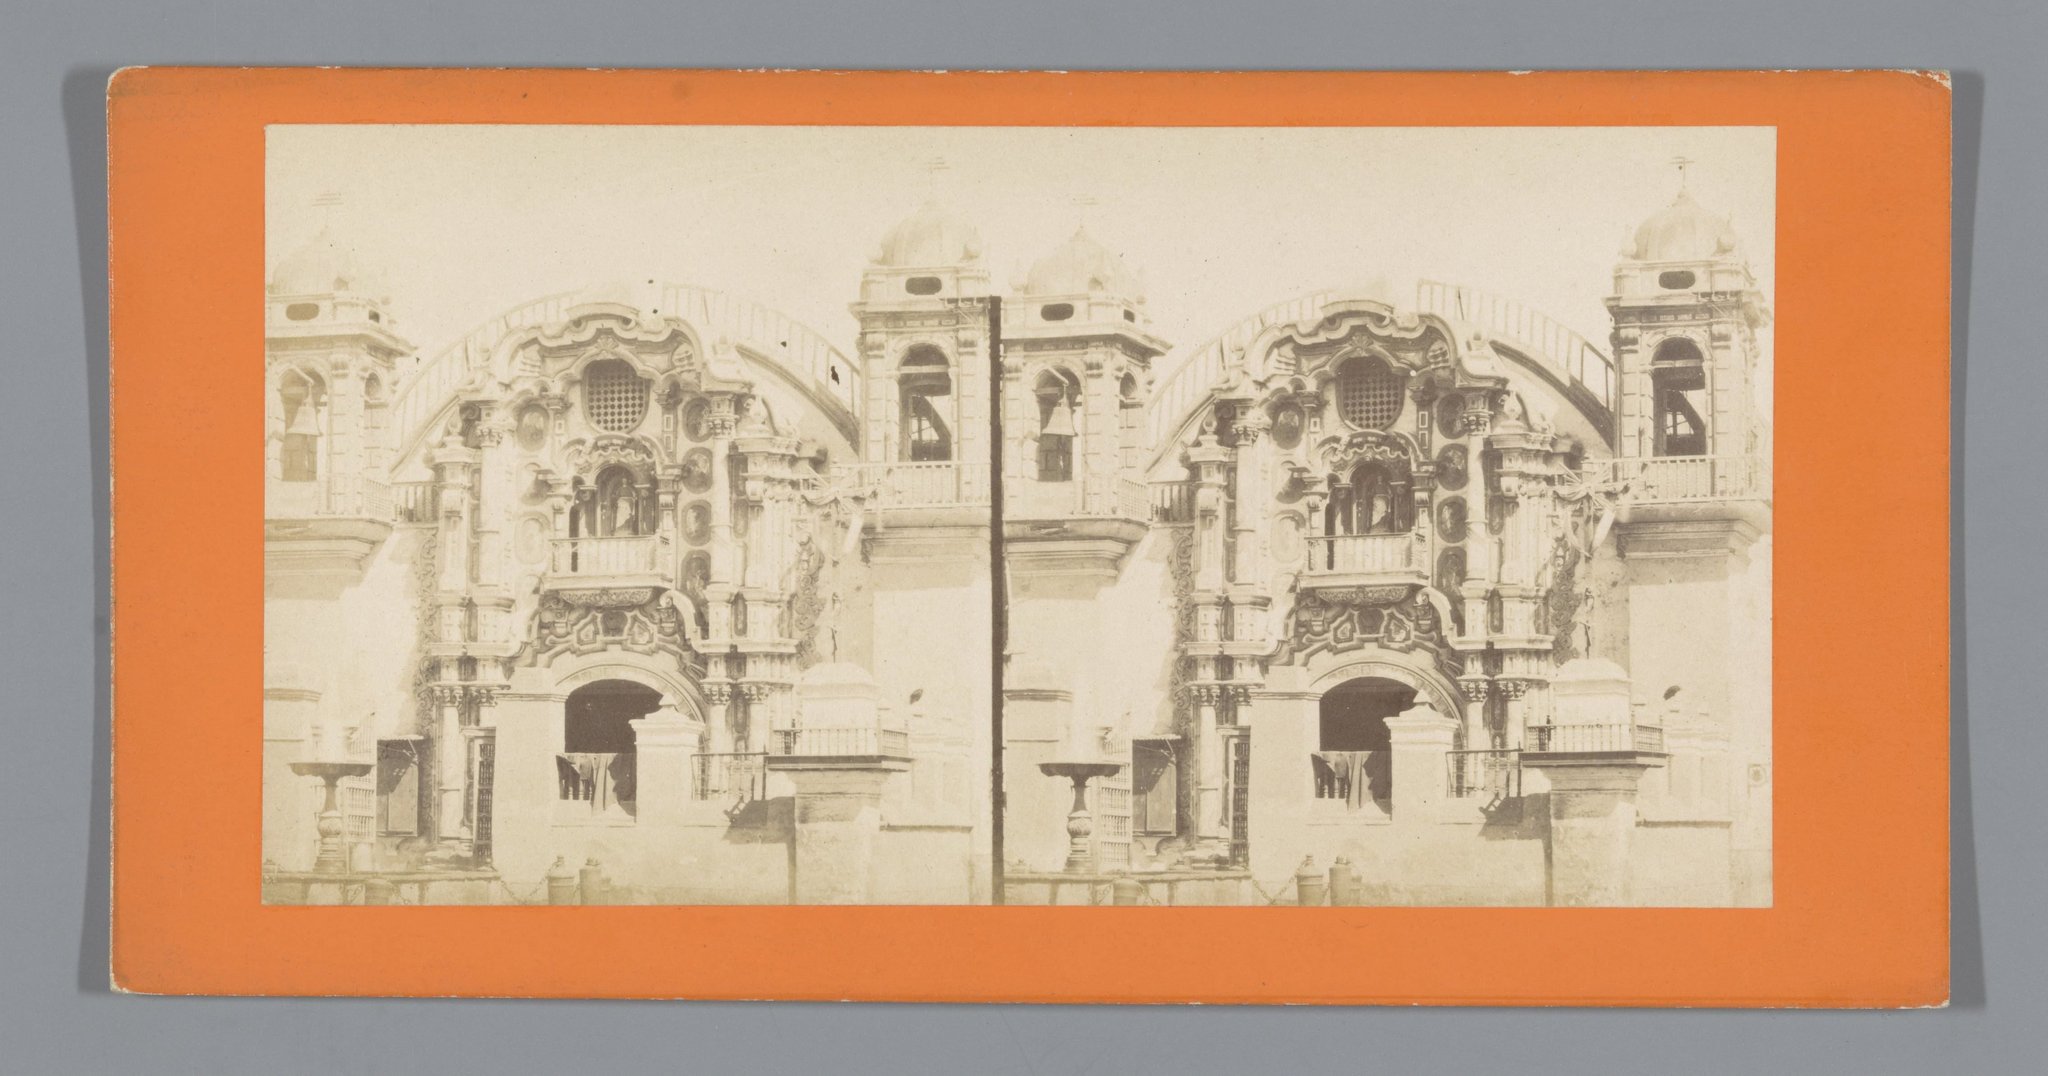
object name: stereograph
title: Gevel van een kerk (vermoedelijk) te Venetië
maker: Anonymous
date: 1850-1880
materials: cardboard, photographic support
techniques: albumen print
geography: venice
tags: church (exterior), façade (of house or building), venice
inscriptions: number: ‘29’, inscription: ‘Fontaine et Eglise de San-Marcelo’